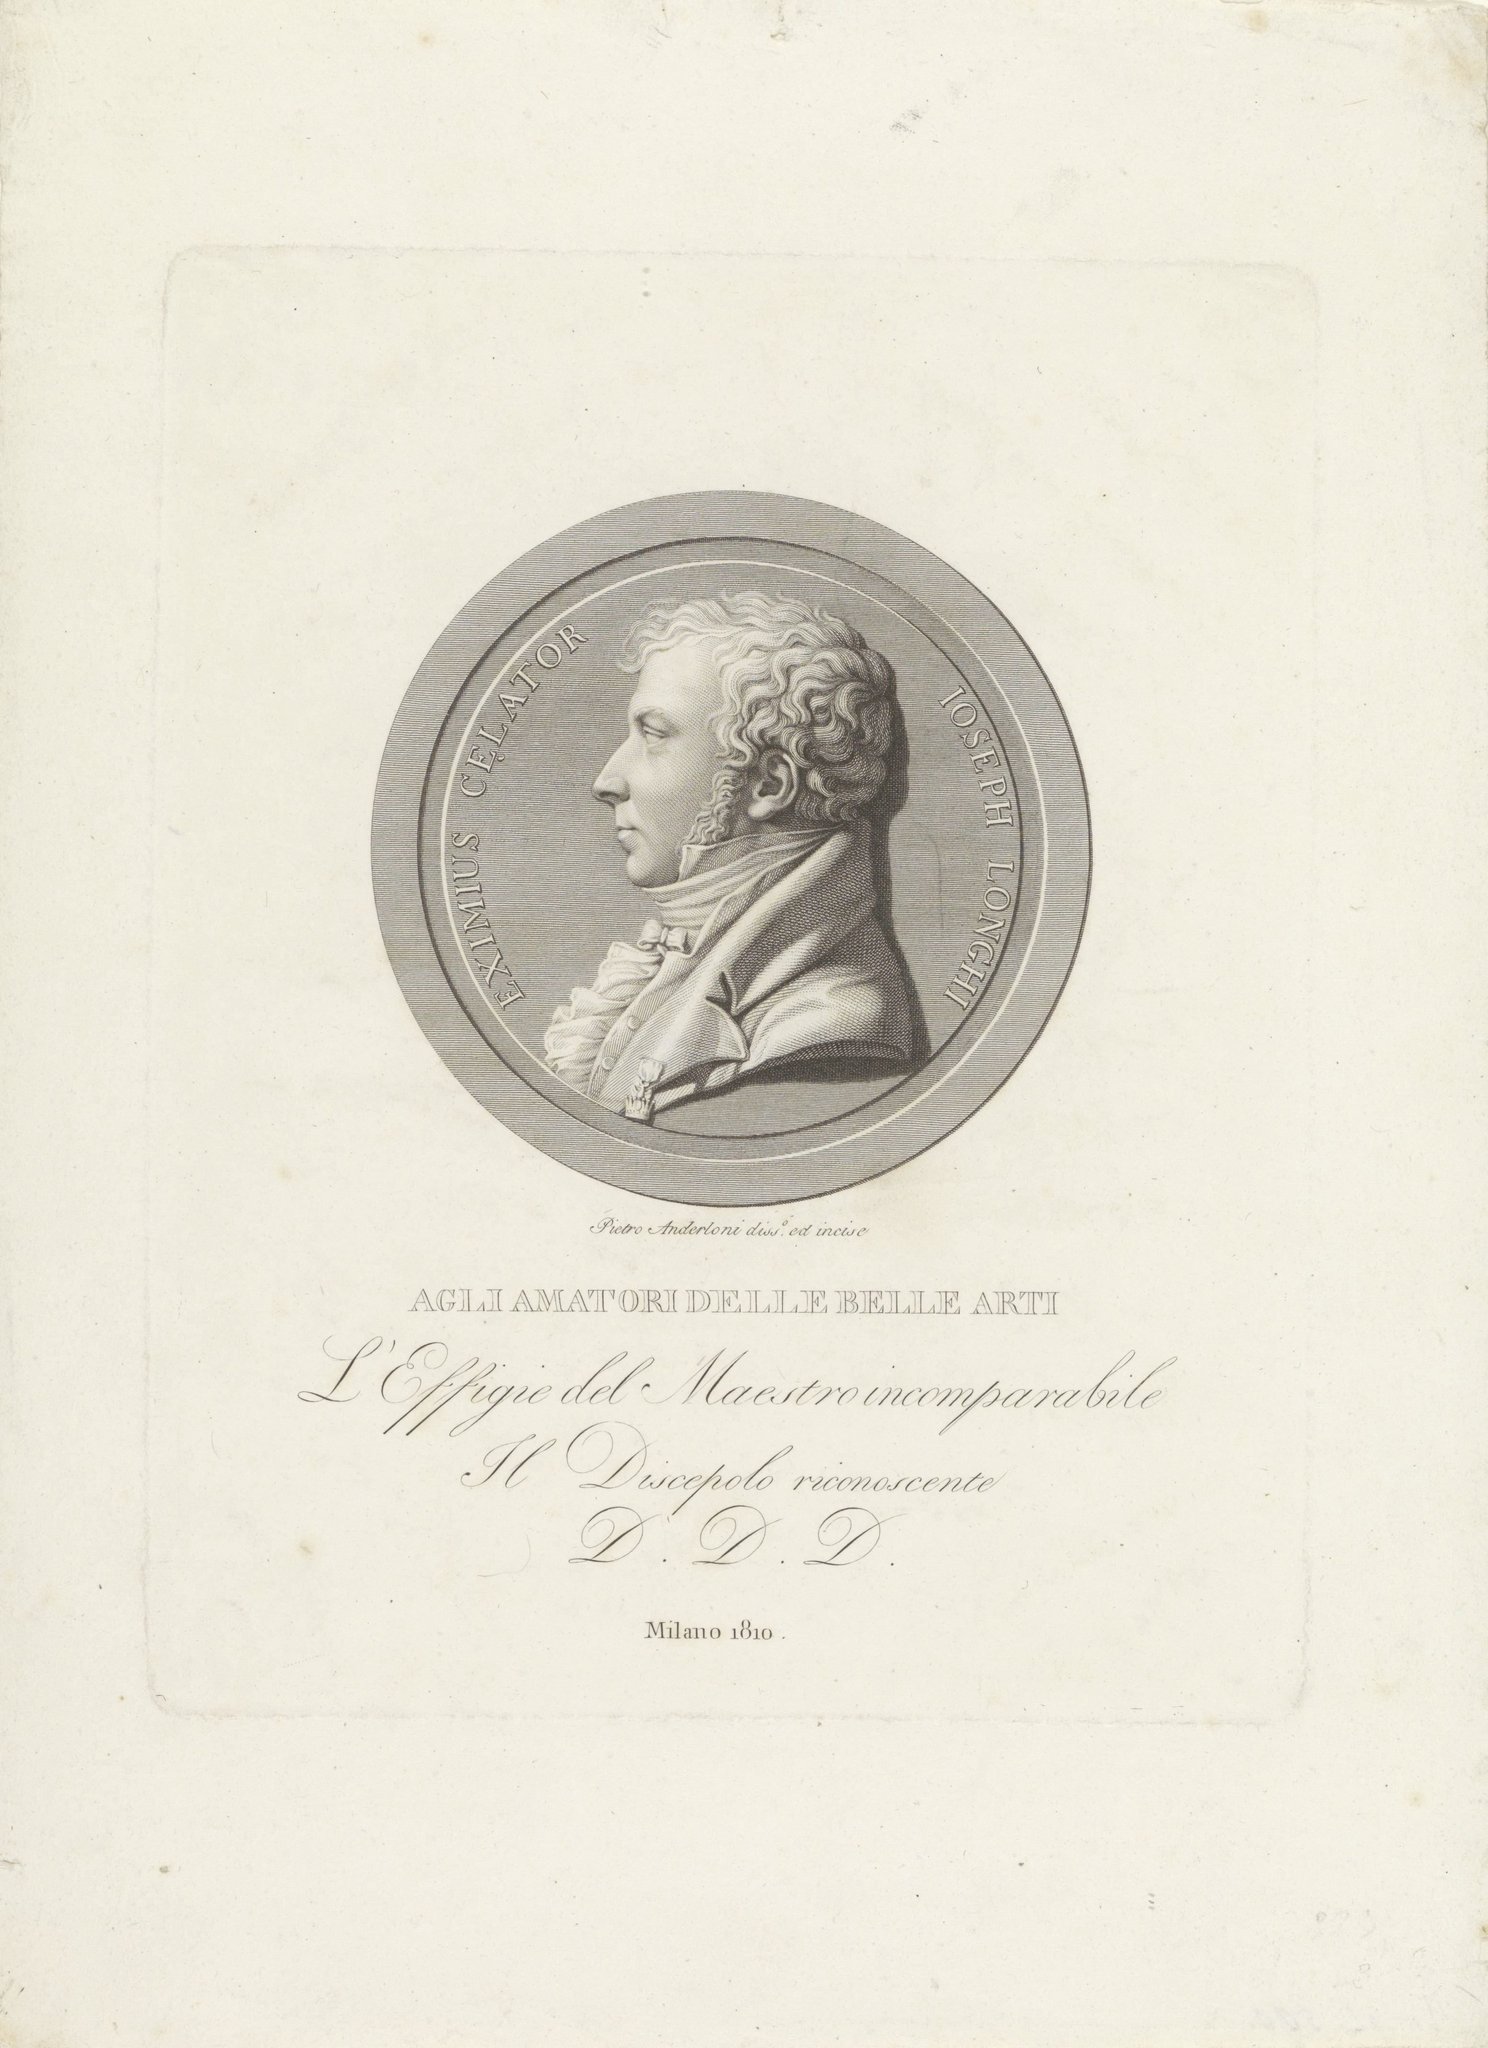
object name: print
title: Portret van Joseph Longhi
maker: pietro anderloni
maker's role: print maker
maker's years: 1785-1849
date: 1810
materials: paper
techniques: engraving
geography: milan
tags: historical persons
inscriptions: collector's mark: Lugt 2228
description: Portret van Joseph Longhi, profiel naar links, in een cirkel. In de ondermarge een tekst in het Italiaans.